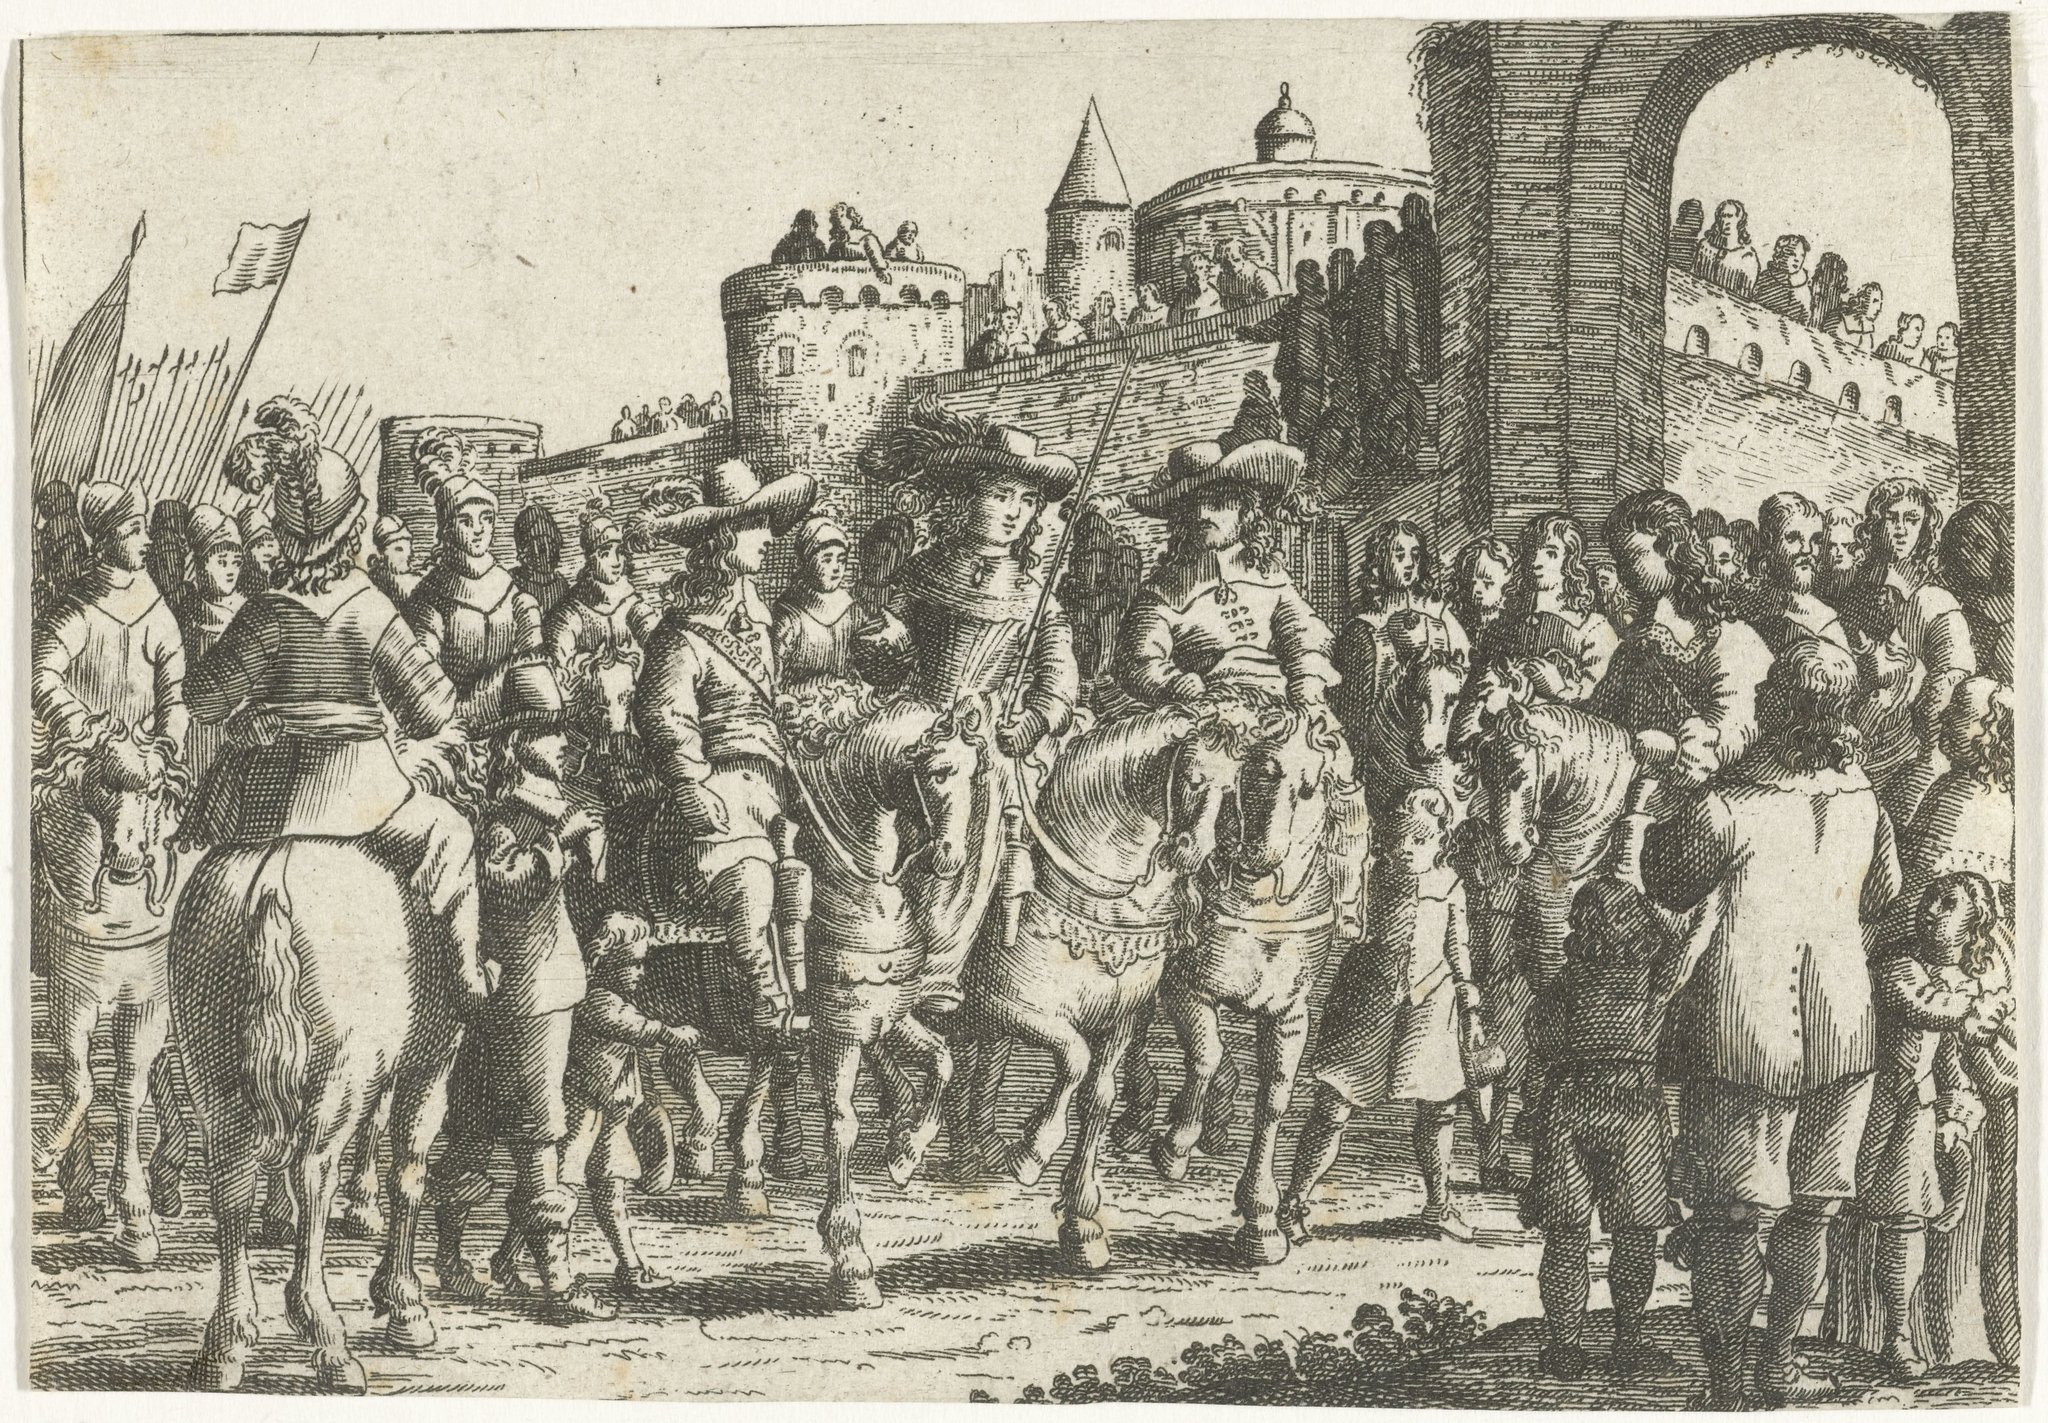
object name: print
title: Ruiters en voetvolk bij een stadspoort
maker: christiaan hagen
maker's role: draughtsman, print maker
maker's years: 1635-1707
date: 1663-1695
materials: paper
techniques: etching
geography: amsterdam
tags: riding a horse, ass, or mule; rider, horseman, city-walls, city-gate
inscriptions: collector's mark: Lugt 2228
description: Een vrouwelijke ruiter met hoed en staf wordt omringd door mannelijke ruiters. Om haar heen hebben zich ook vele figuren te voet verzameld, onder andere op de stadsmuren. Rechts een poort.